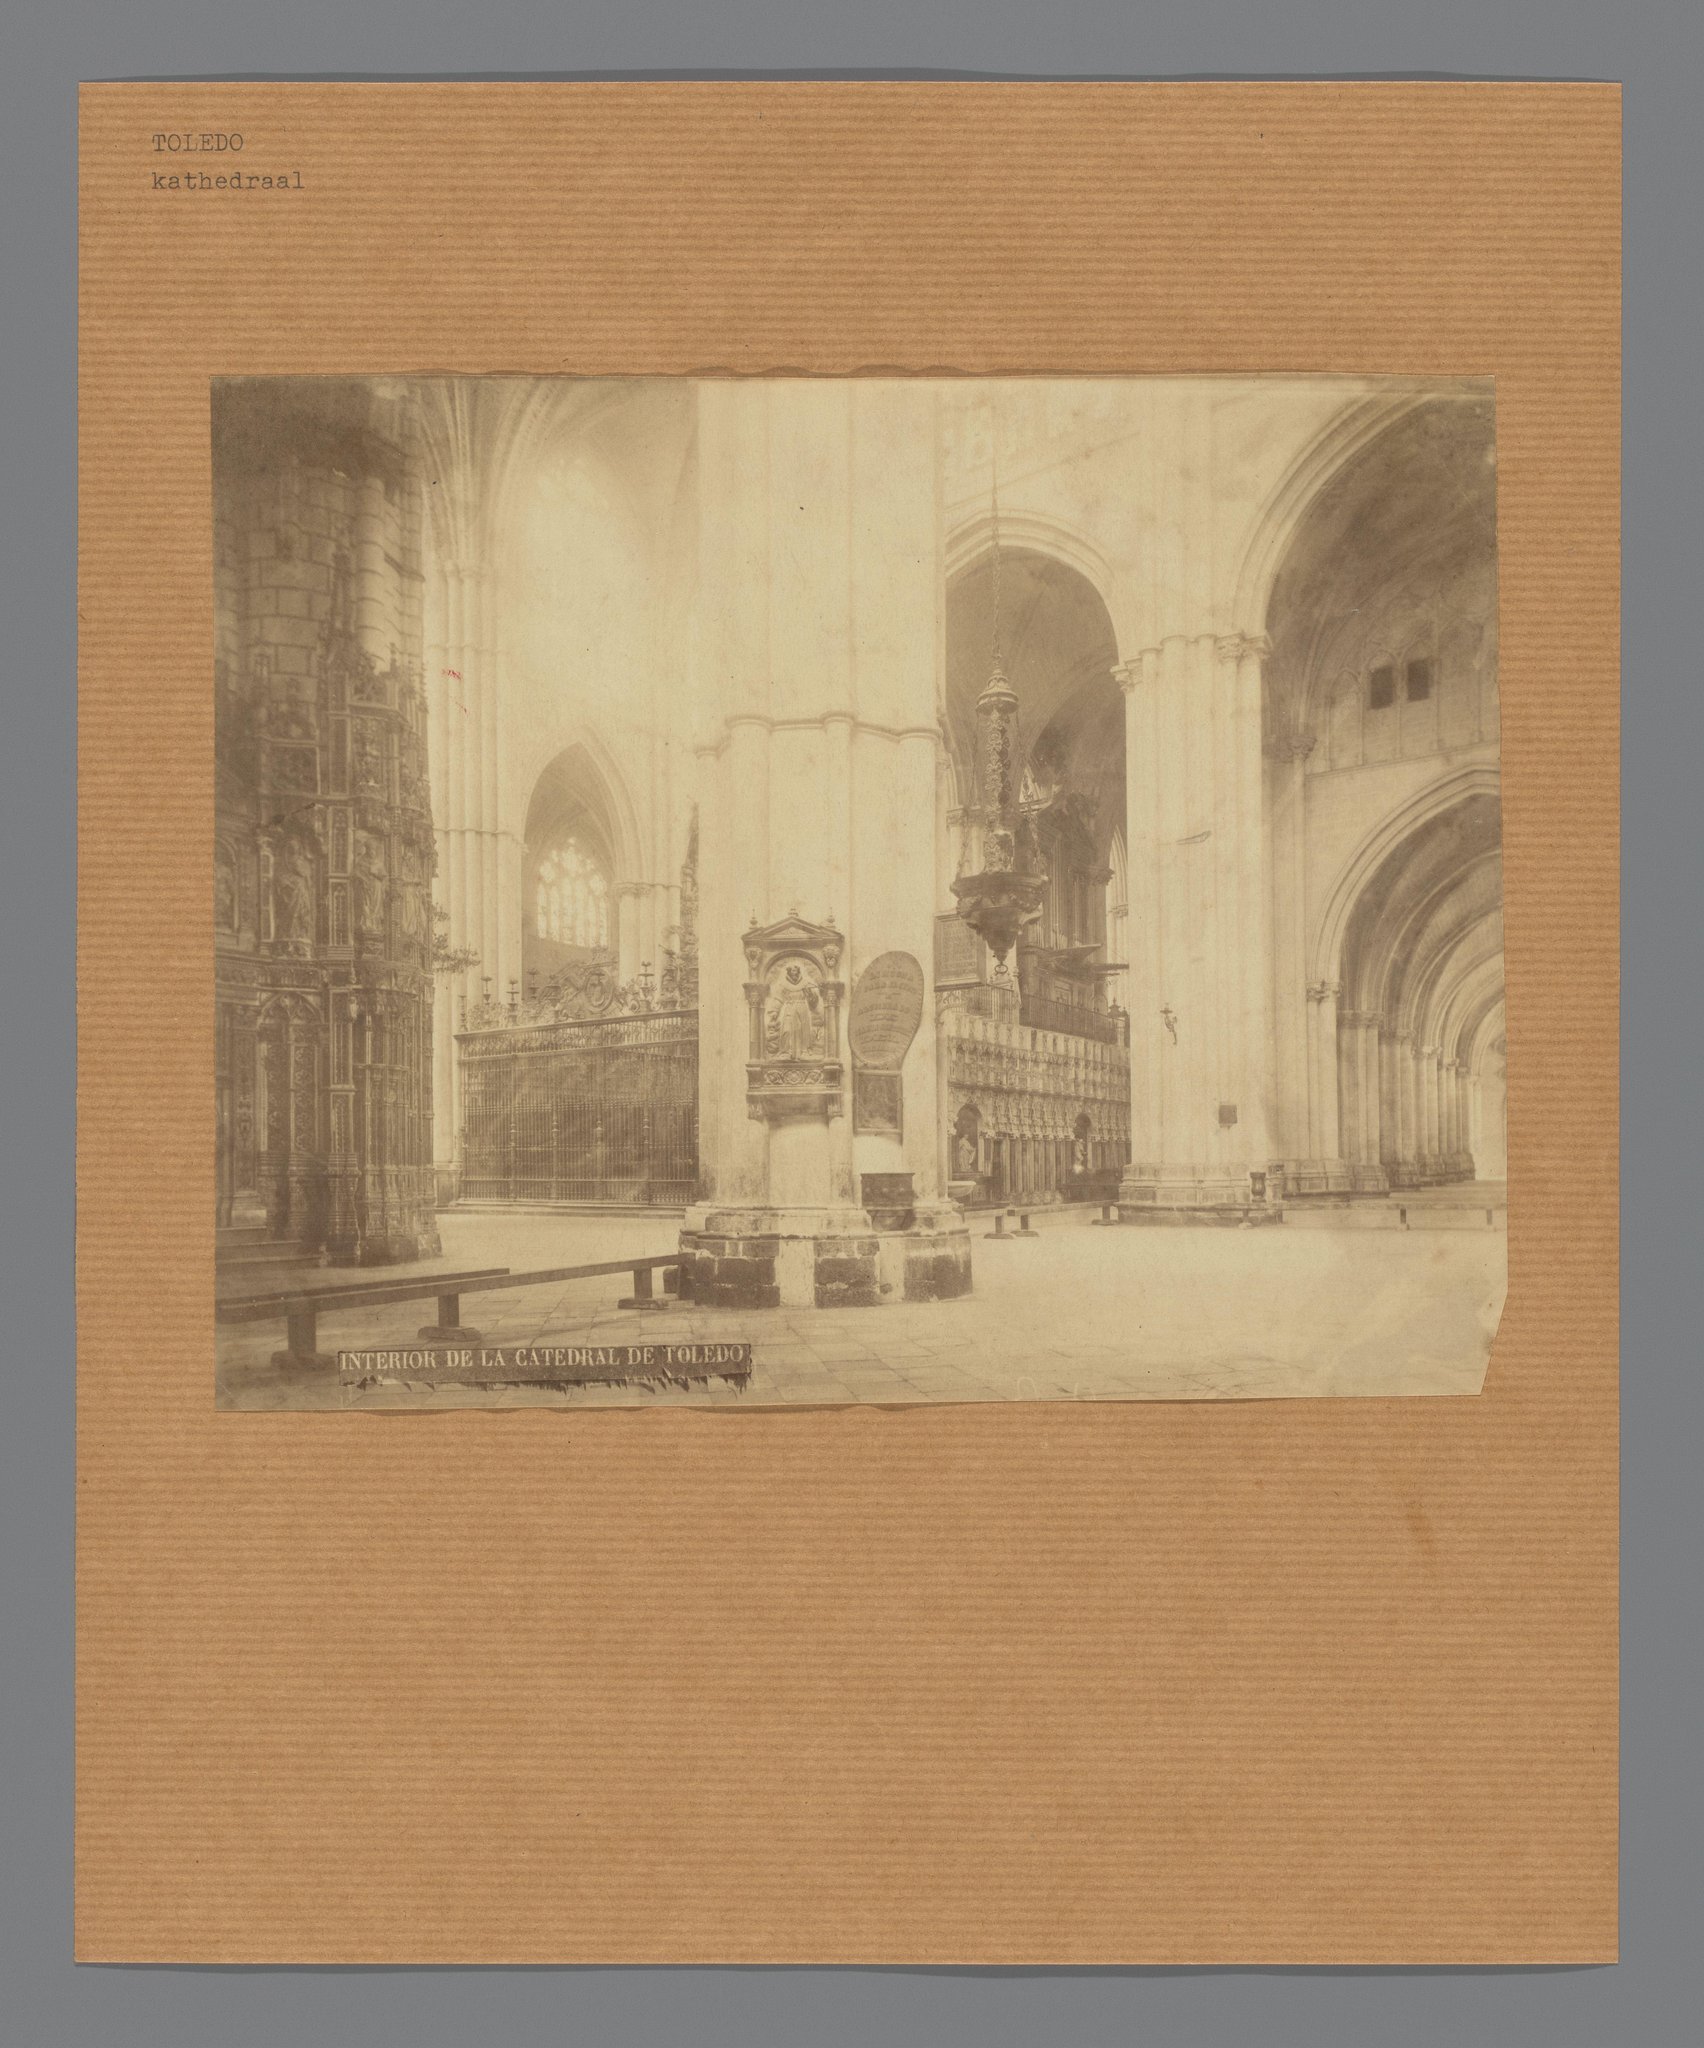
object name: photograph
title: Interieur van de kathedraal te Toledo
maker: Anonymous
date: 1850-1899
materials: paper, photographic support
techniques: albumen print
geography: spain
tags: toledo cathedral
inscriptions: inscription, stamp: ‘UNIVERSITEIT VAN AMSTERDAM / KUNST / HISTORISCH / INSTITUUT’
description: Foto uit de studiecollectie van het Kunsthistorisch Instituut van de Universiteit van Amsterdam.